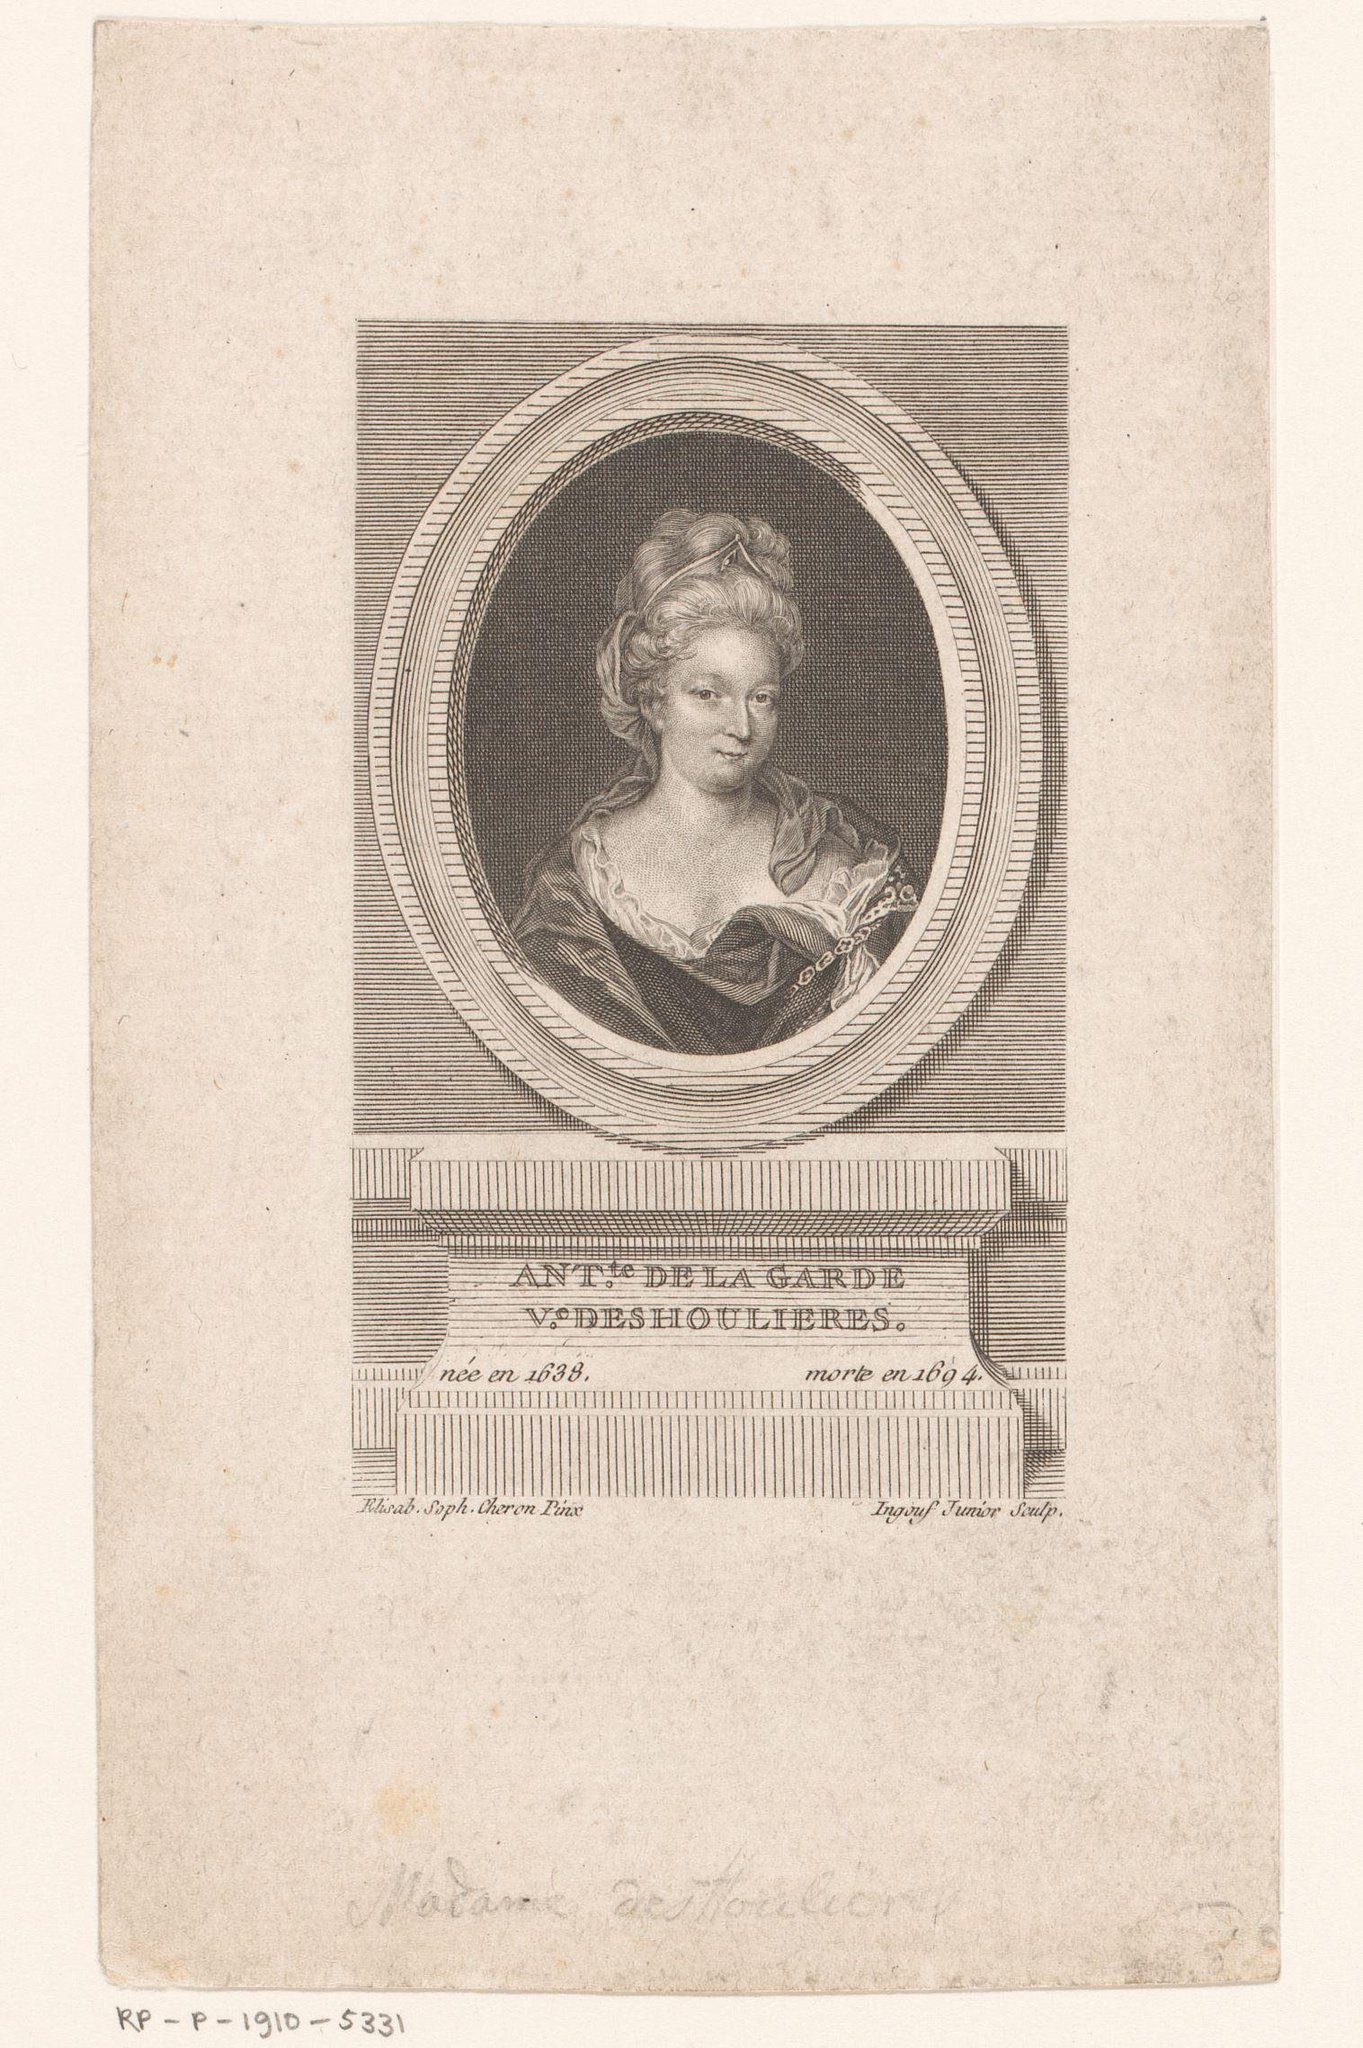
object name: book illustration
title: Portret van Antoinette Du Ligier de la Garde Deshoulières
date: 1778-1787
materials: paper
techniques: engraving, etching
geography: paris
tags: paris, literature ~ arts, historical persons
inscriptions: collector's mark: Lugt 2228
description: Prent uit: Annales poétiques, ou Almanach des Muses. Parijs: Delalain, 1778-1787, dl. 28.